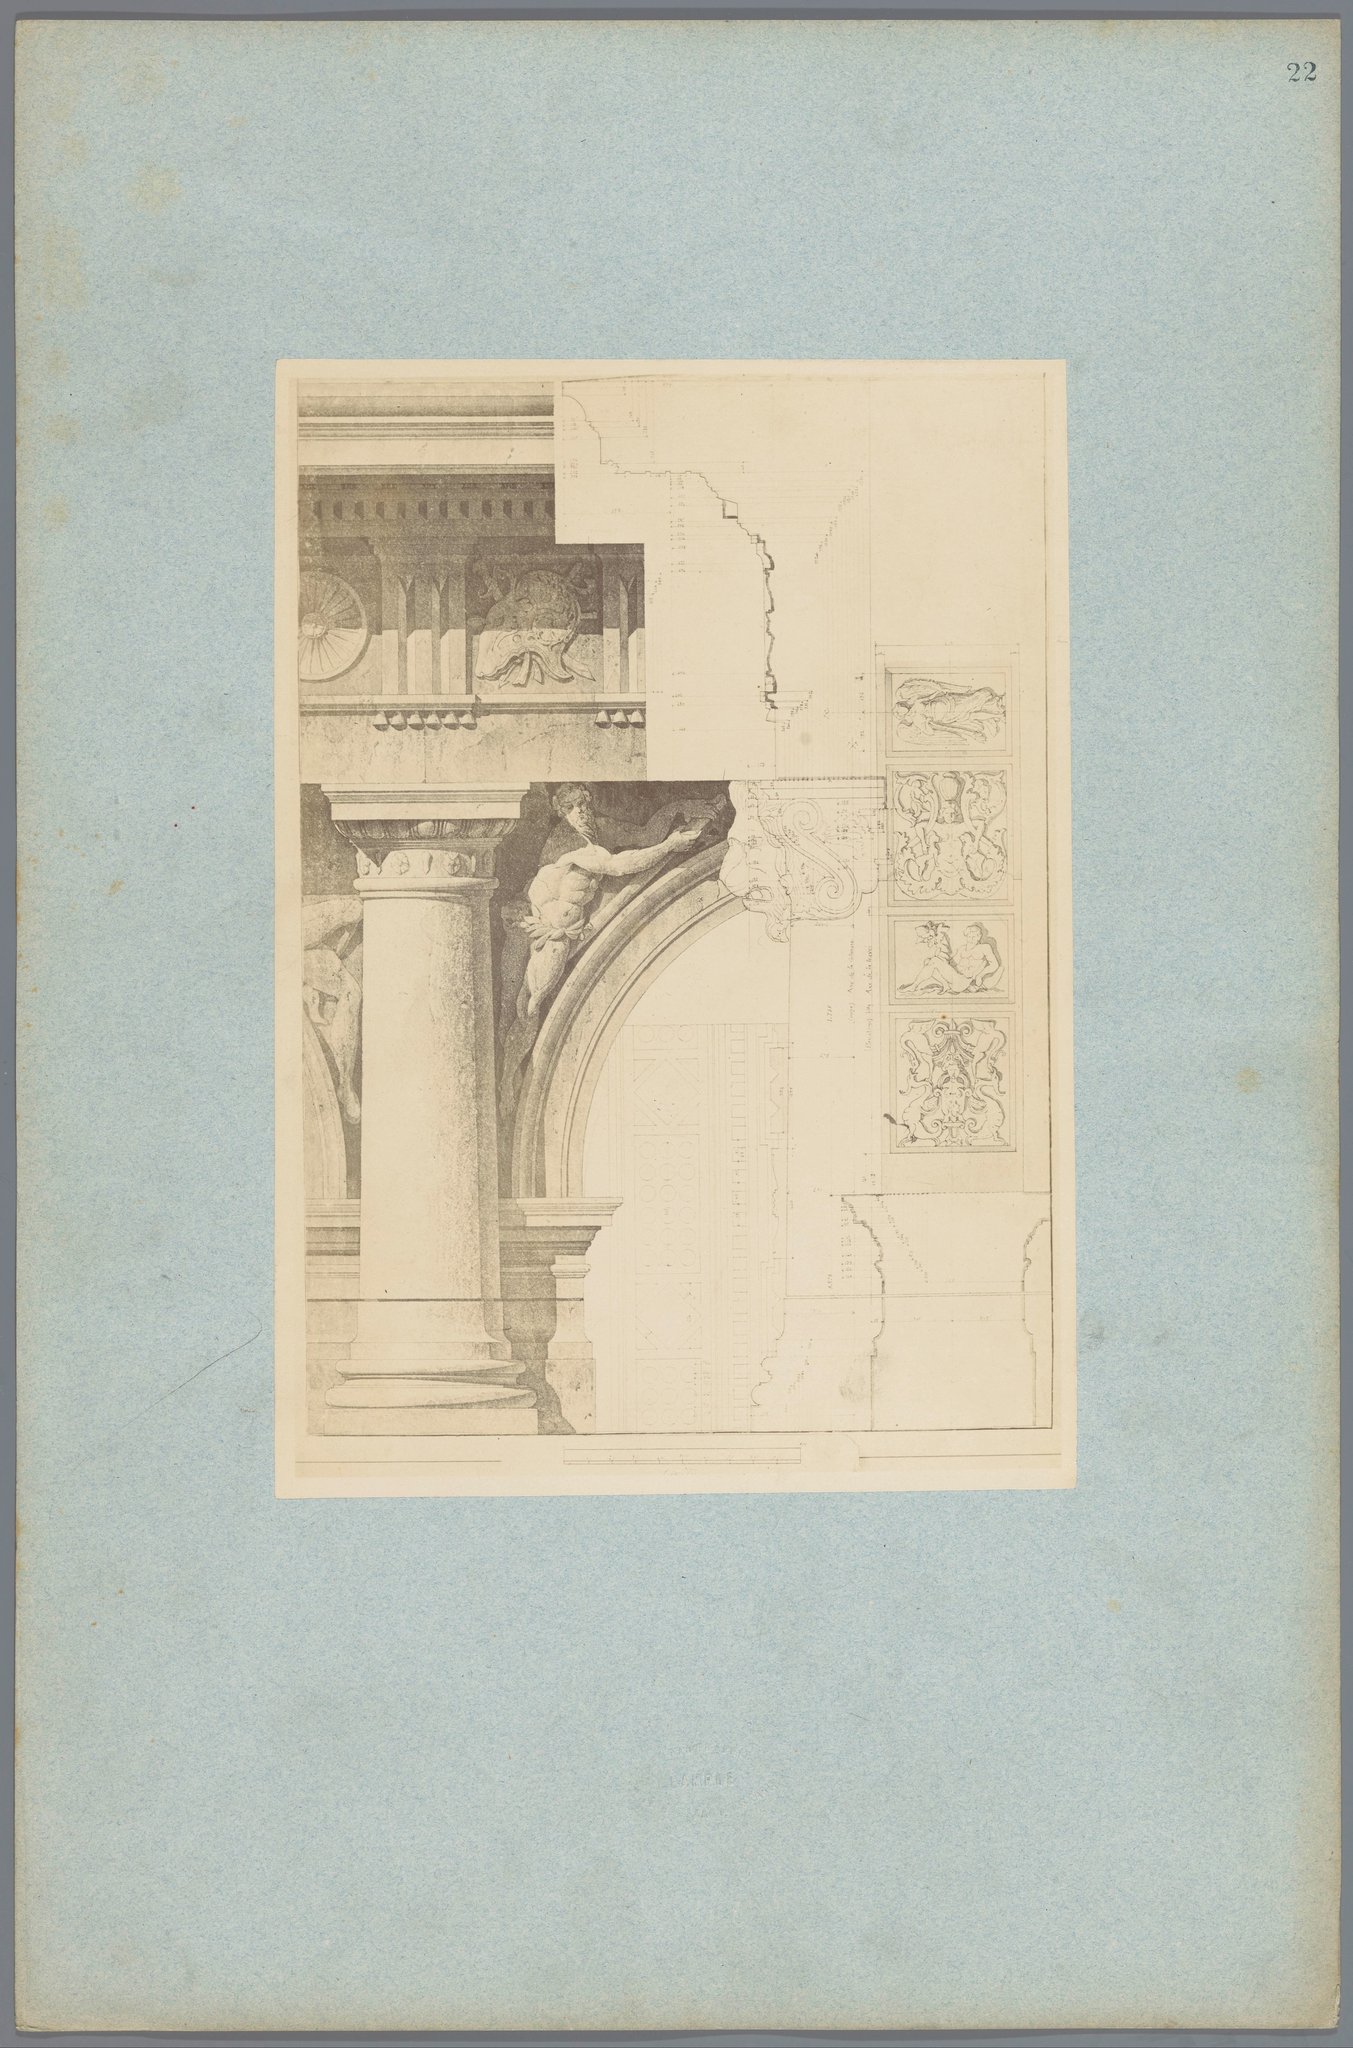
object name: photograph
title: Fotoreproductie van een architectonische tekening van een gebouw met daarin de verhoudingen en formaten vermeld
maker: jean pierre emanuel lampué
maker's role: fotograaf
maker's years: 1836-1924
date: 1875-1900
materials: cardboard, photographic support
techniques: albumen print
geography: europe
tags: drawing, sketch, drawing, measuring, calculating, arch, archivolt ~ architecture, europe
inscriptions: collector's mark: Lugt 3937, number: ‘22’, name: ‘PHOTOGRAPHIE LAMPUÉ 237, R. St. JAQUES, PARIS’